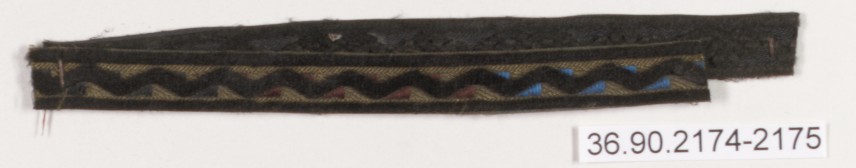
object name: piece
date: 1801-1900